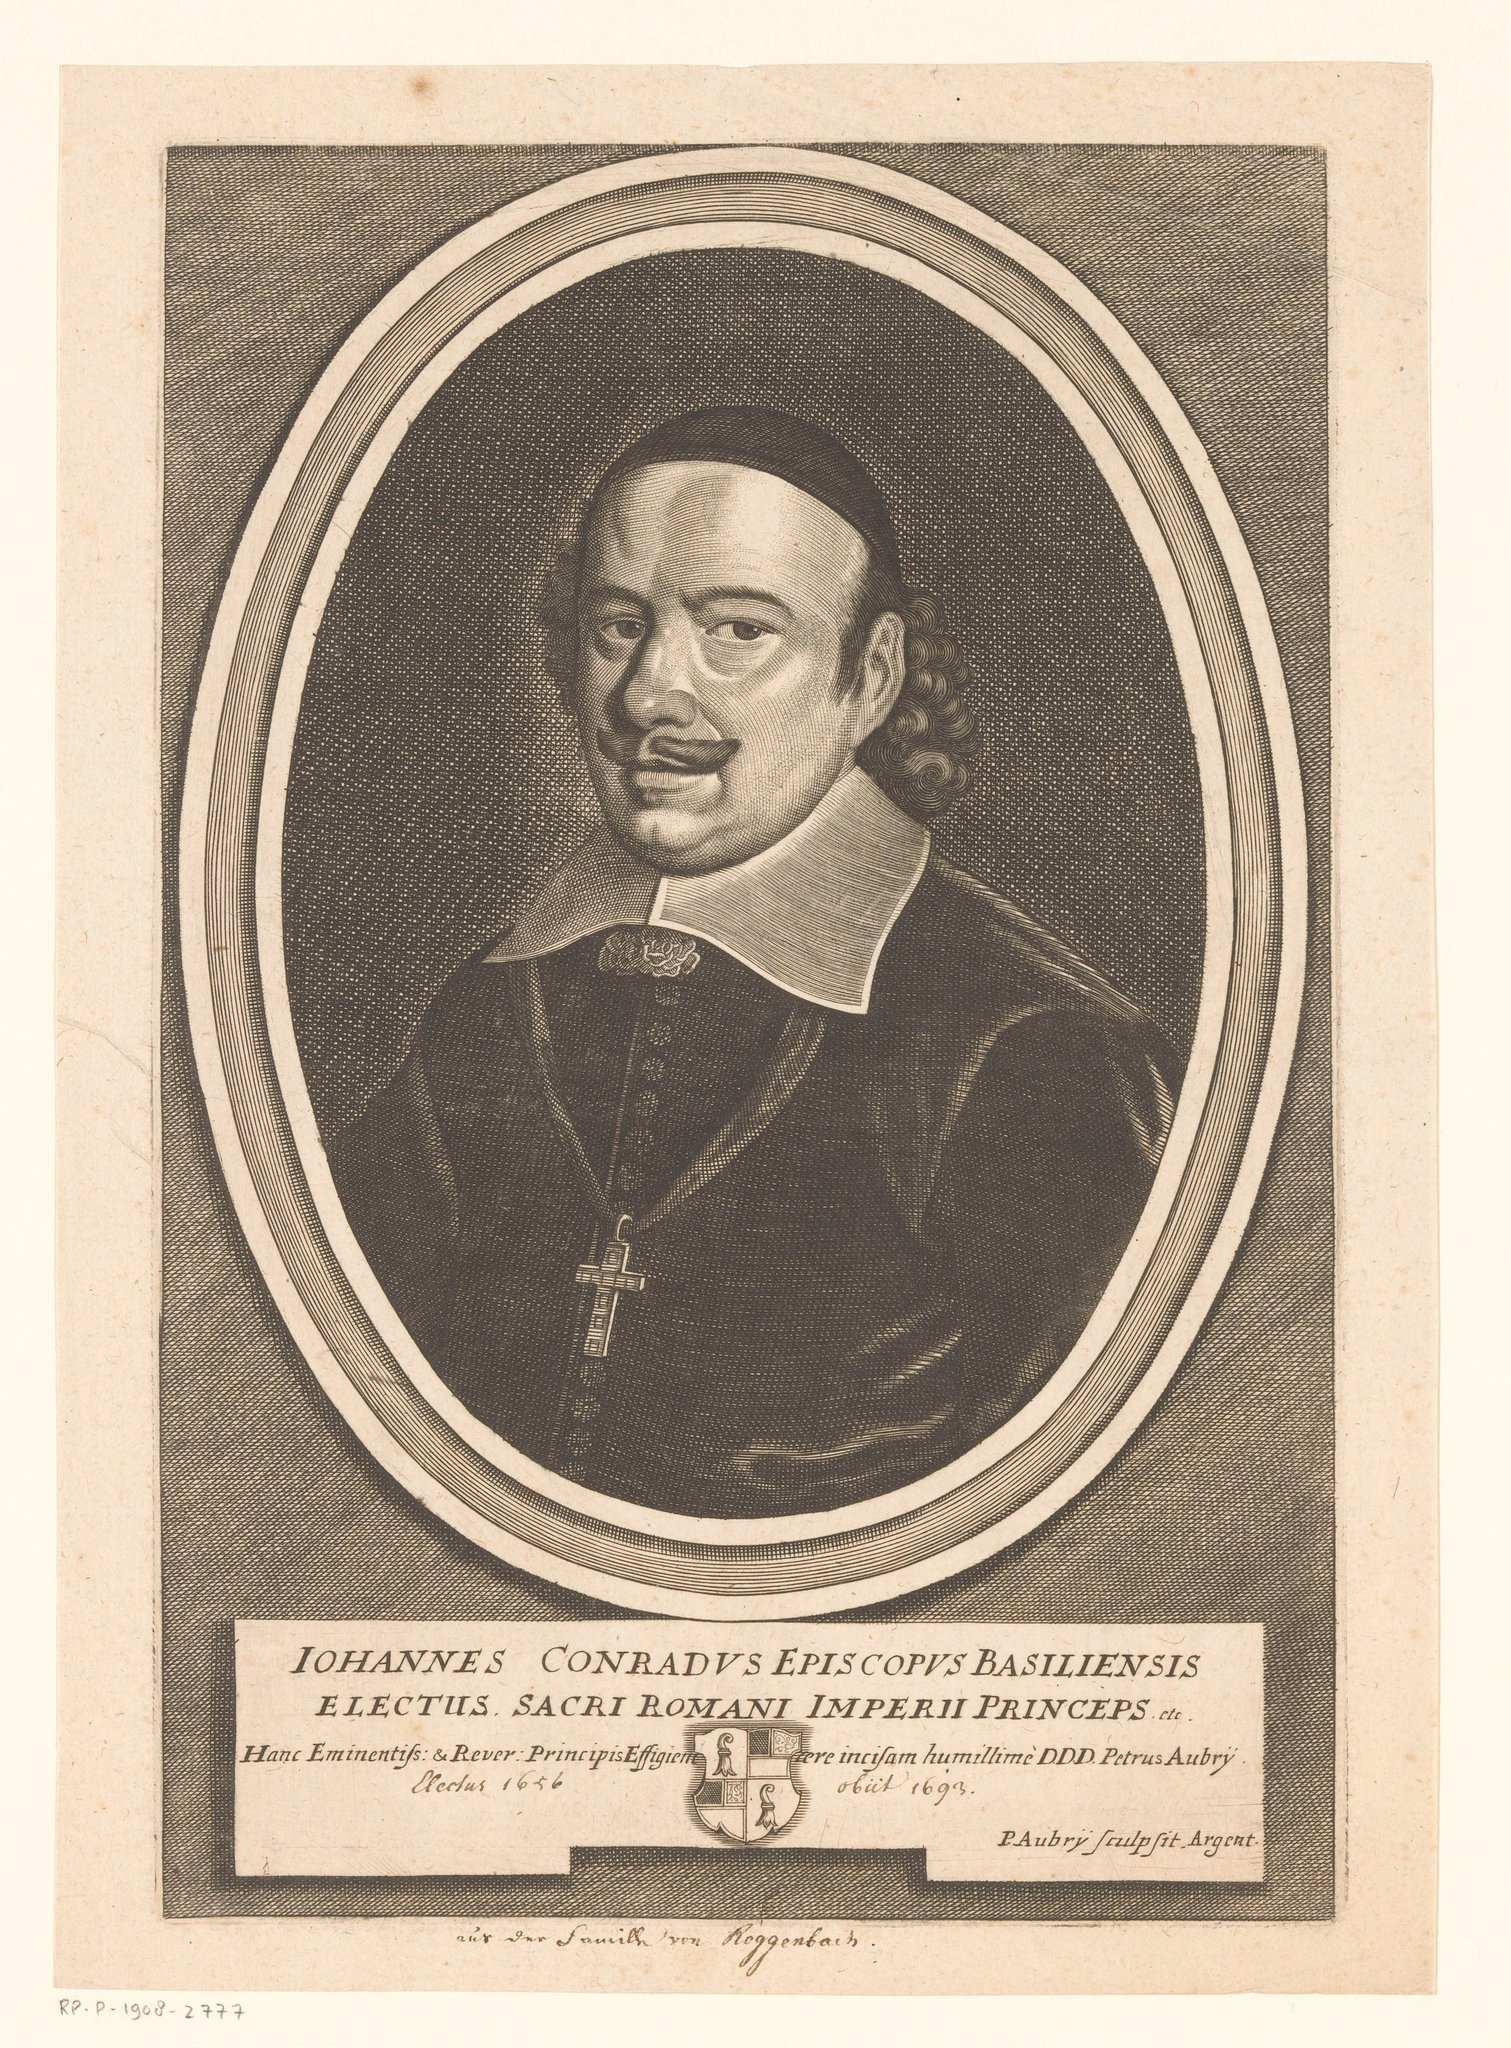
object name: print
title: Portret van Johann Konrad, bisschop van Bazel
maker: peter aubry (iii)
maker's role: print maker, publisher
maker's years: 1610-1686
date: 1658-1686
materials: paper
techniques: engraving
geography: straatsburg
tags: historical persons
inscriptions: inscription: ‘electus 1656 / obiit 1693 // aus der famille von Roggenbach’, collector's mark: Lugt 2228